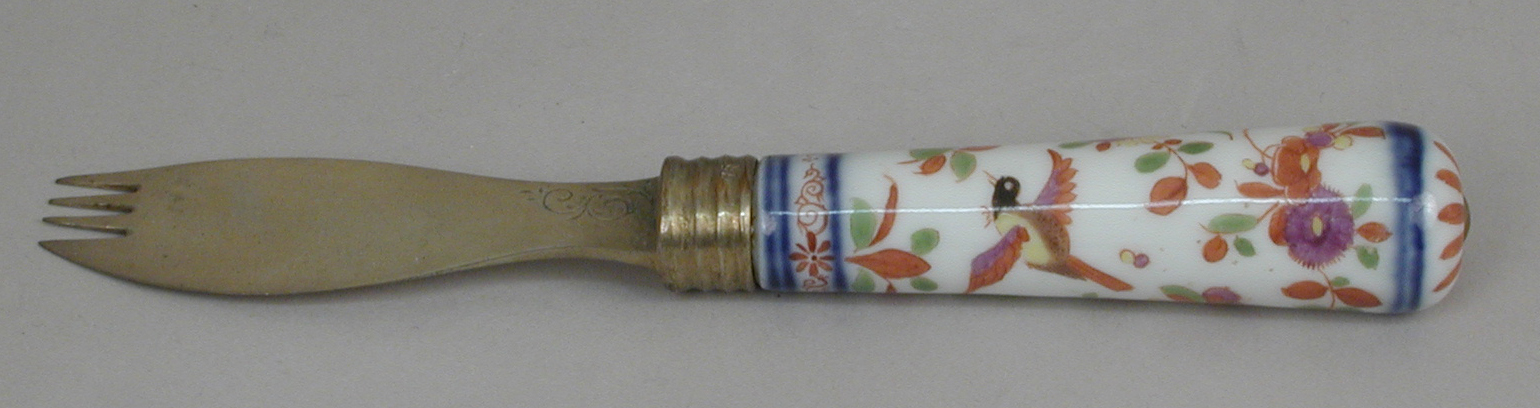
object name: knife and fork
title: Fork or knife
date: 1801-1900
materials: porcelain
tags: birds,flowers